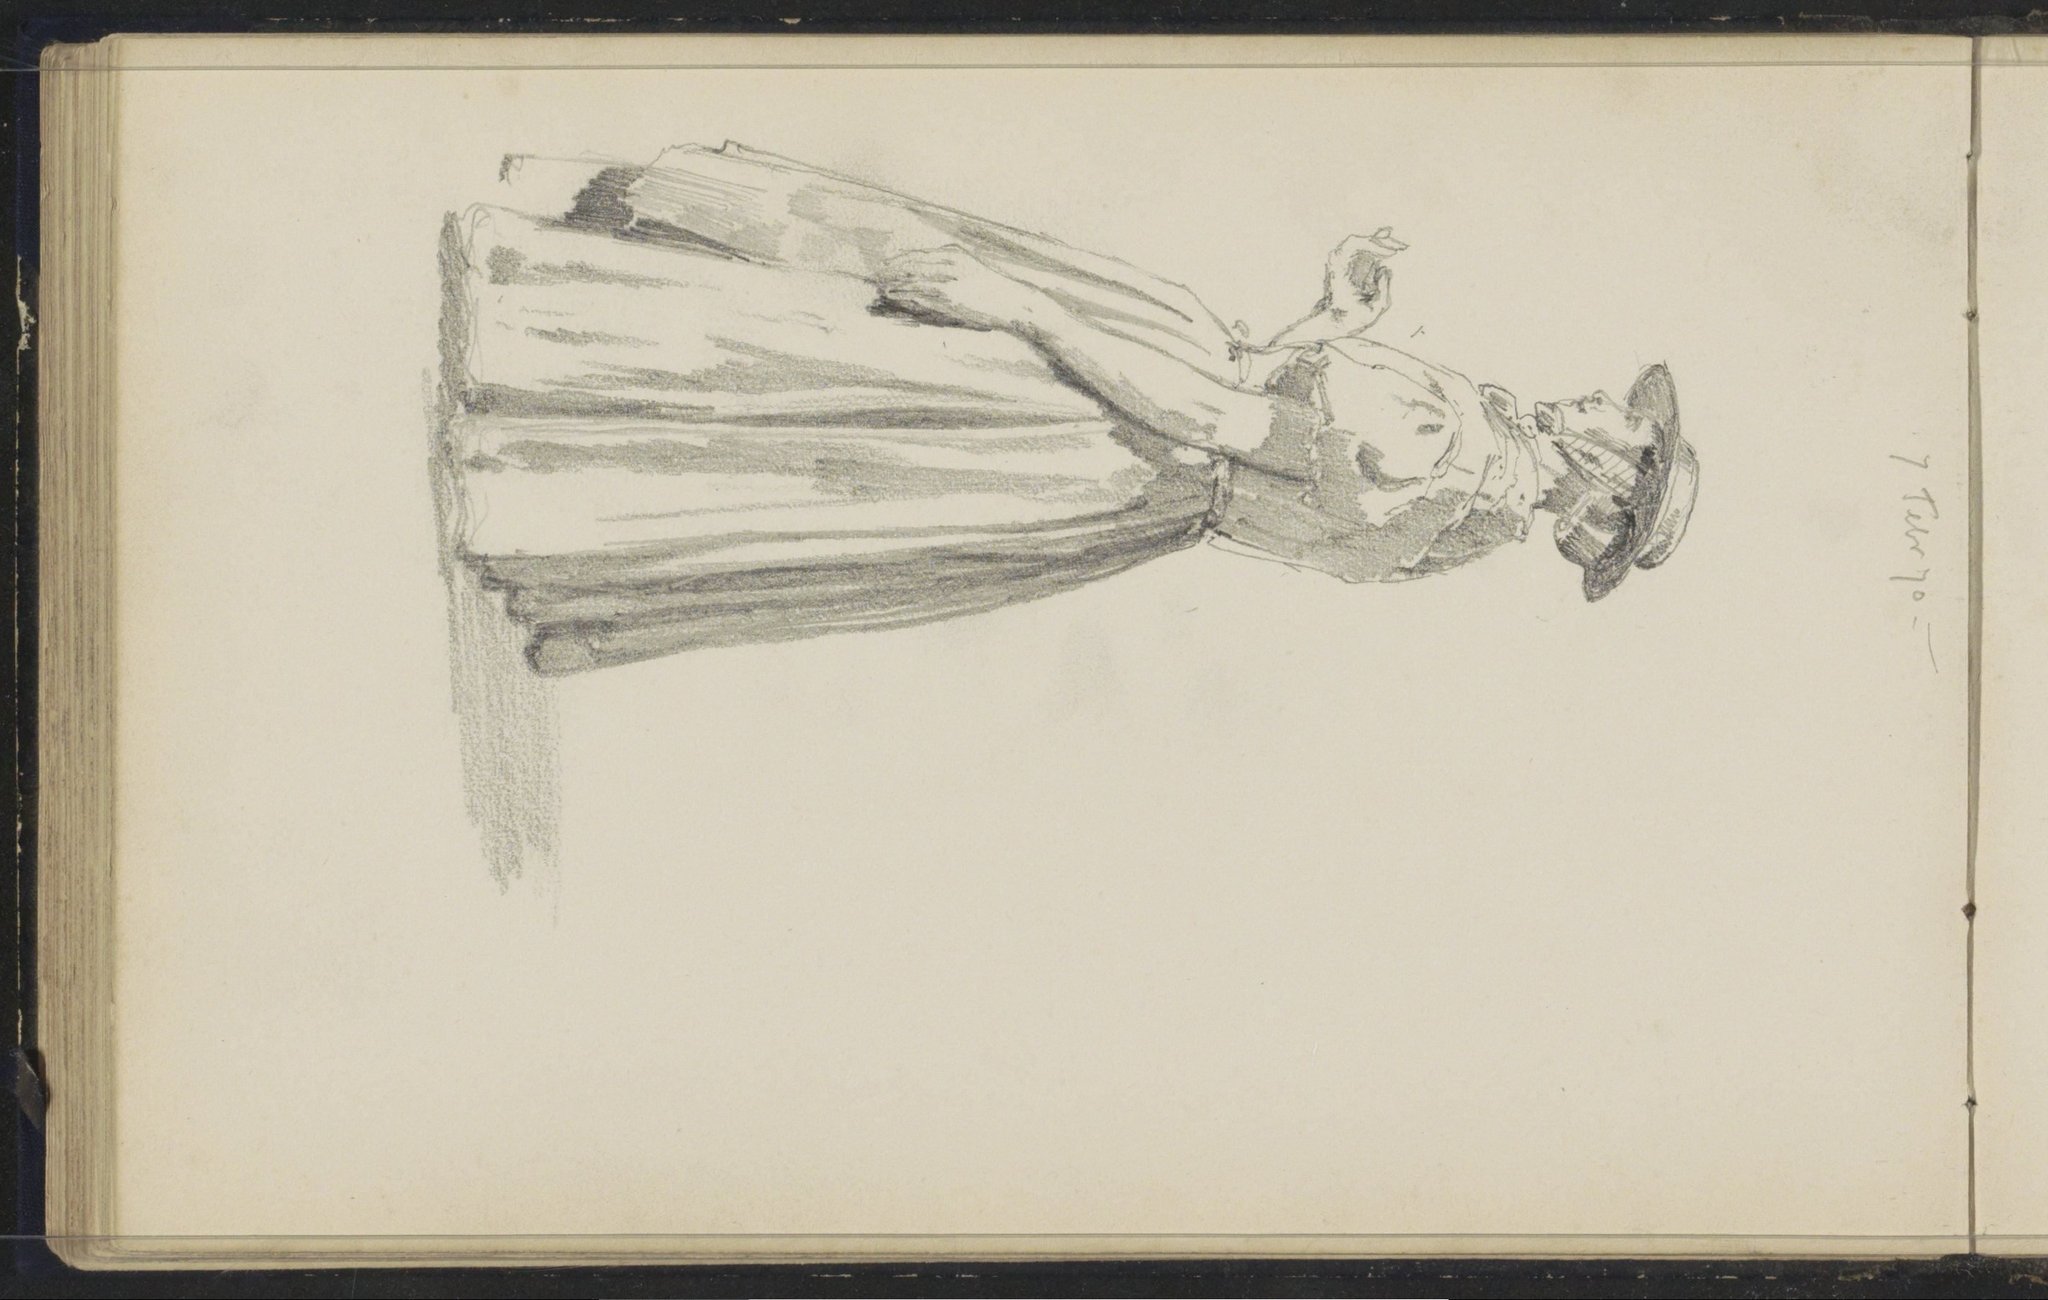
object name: sketchbook leaf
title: Vrouw met een hoed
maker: cornelis springer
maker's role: draughtsman, painter, print maker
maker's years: 1817-1891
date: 1870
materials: paper, pencil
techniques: stumping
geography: netherlands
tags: standing figure - aa - female human figure (+ sideview, profile), head-gear: hat (+ women's clothes)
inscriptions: date: ‘7 Febr 70’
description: Vrouw met een hoed, in profiel naar links. Blad 28 verso uit een schetsboek met 40 bladen, vervaardigd in Woerden en Gouda.